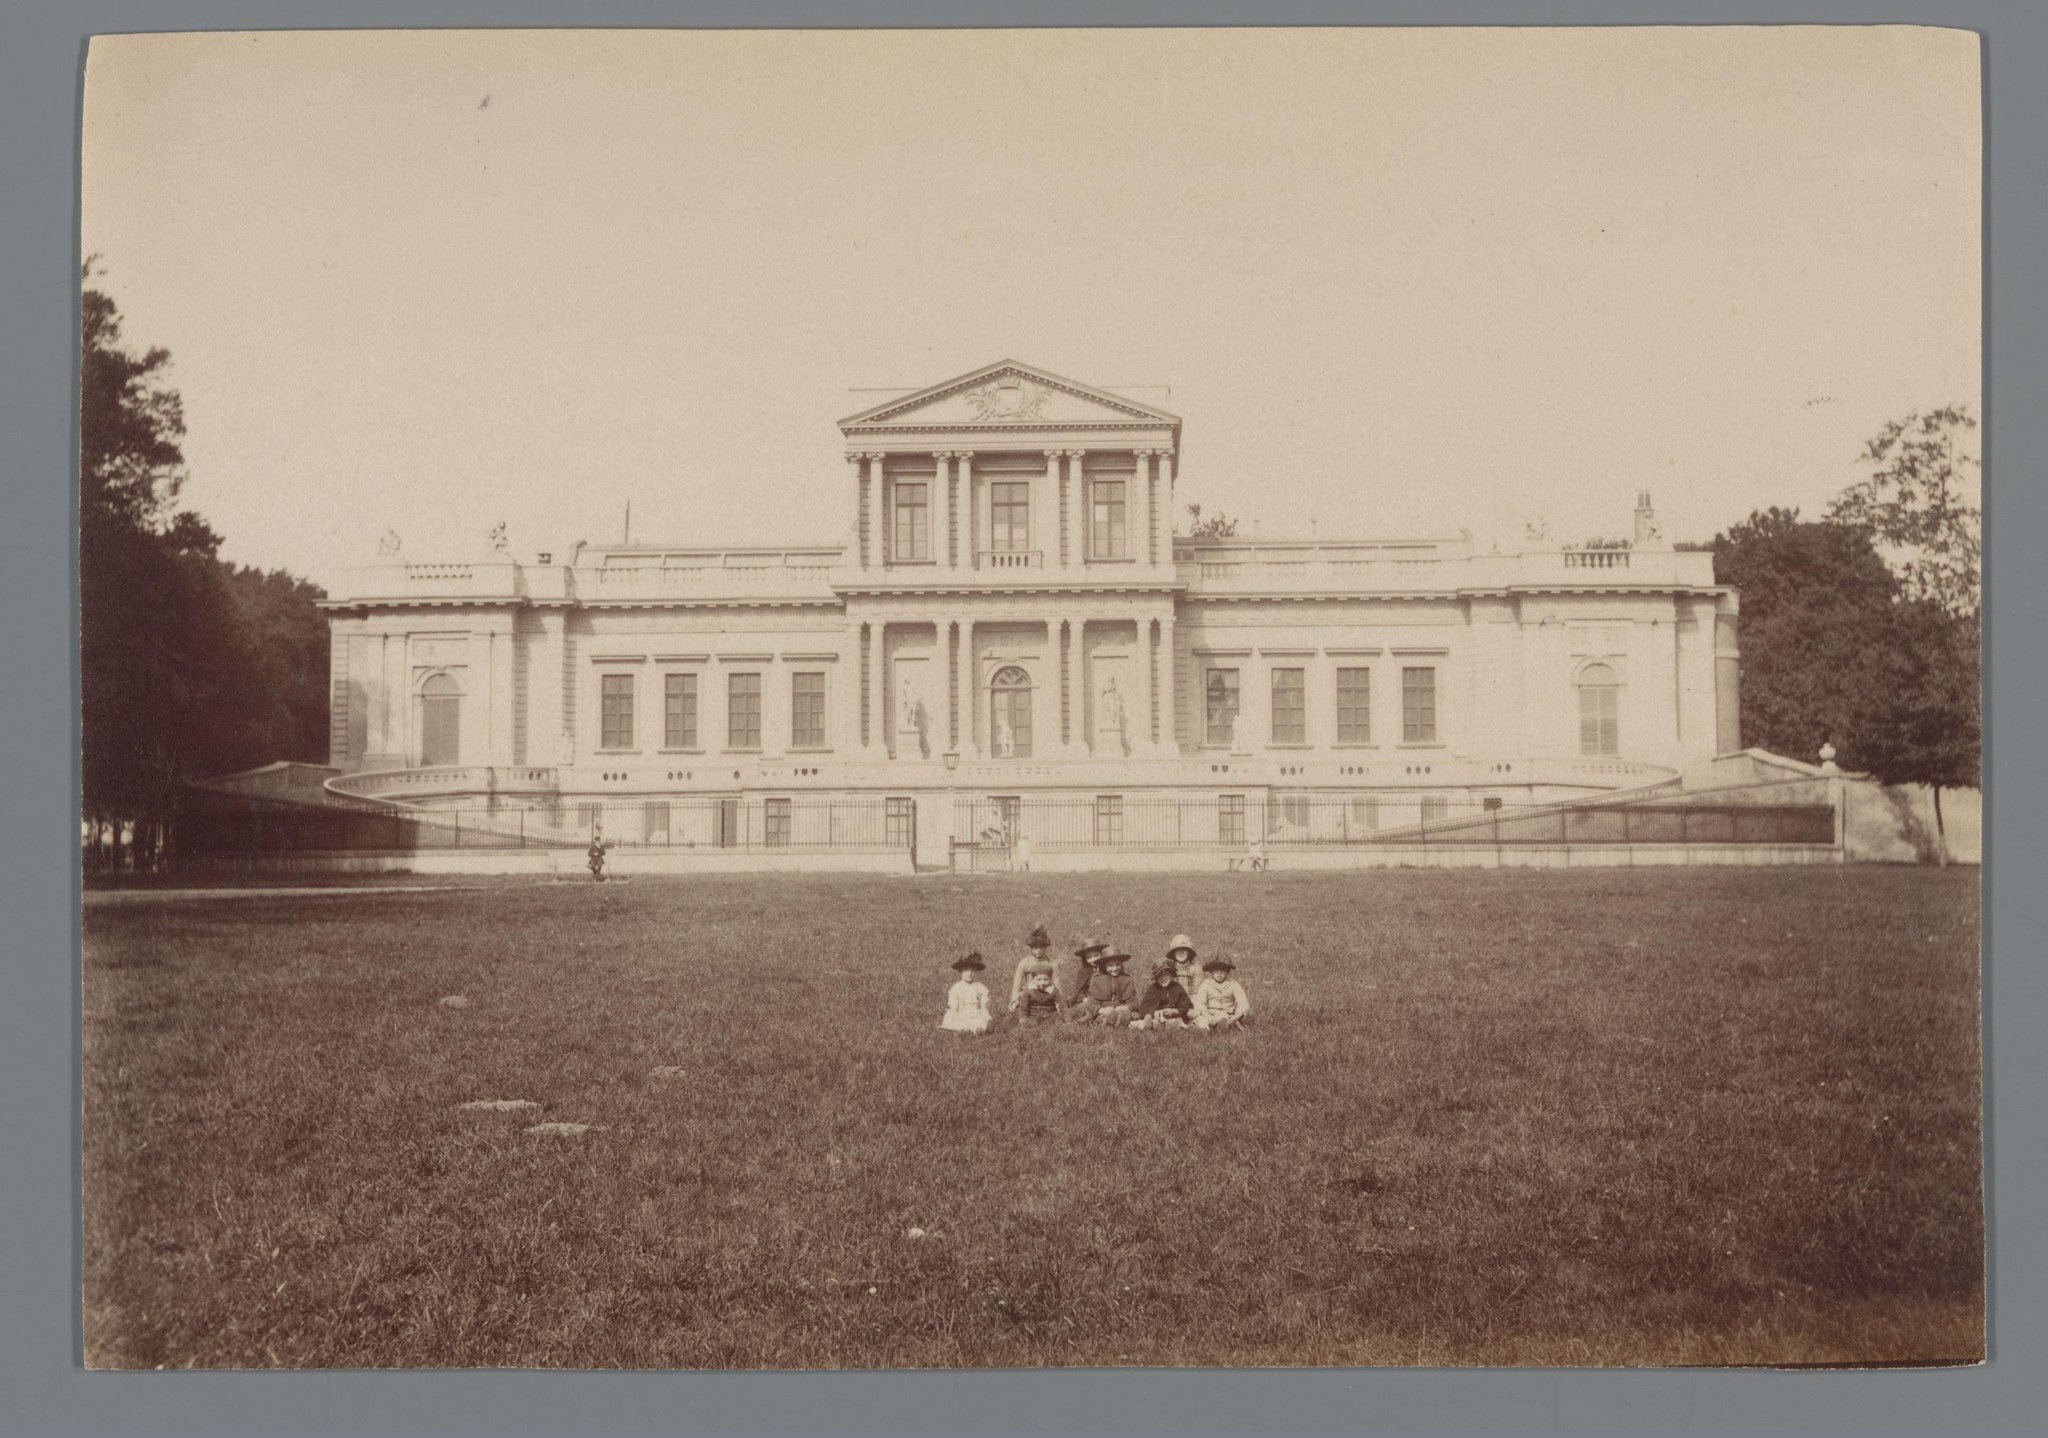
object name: photograph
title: Paviljoen Welgelegen te Haarlem, met kinderen zittend op het gras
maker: andries jager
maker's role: publisher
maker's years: 1825-1905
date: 1870-1900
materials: cardboard, photographic support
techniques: albumen print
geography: haarlem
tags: civic architecture; edifices; dwellings, anonymous historical persons portrayed in a group, in a group-portrait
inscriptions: annotation: ‘(top. K3: Haarlem I)/ A. Jager - ook . Felix van West zelfde personen/ leporello H)’